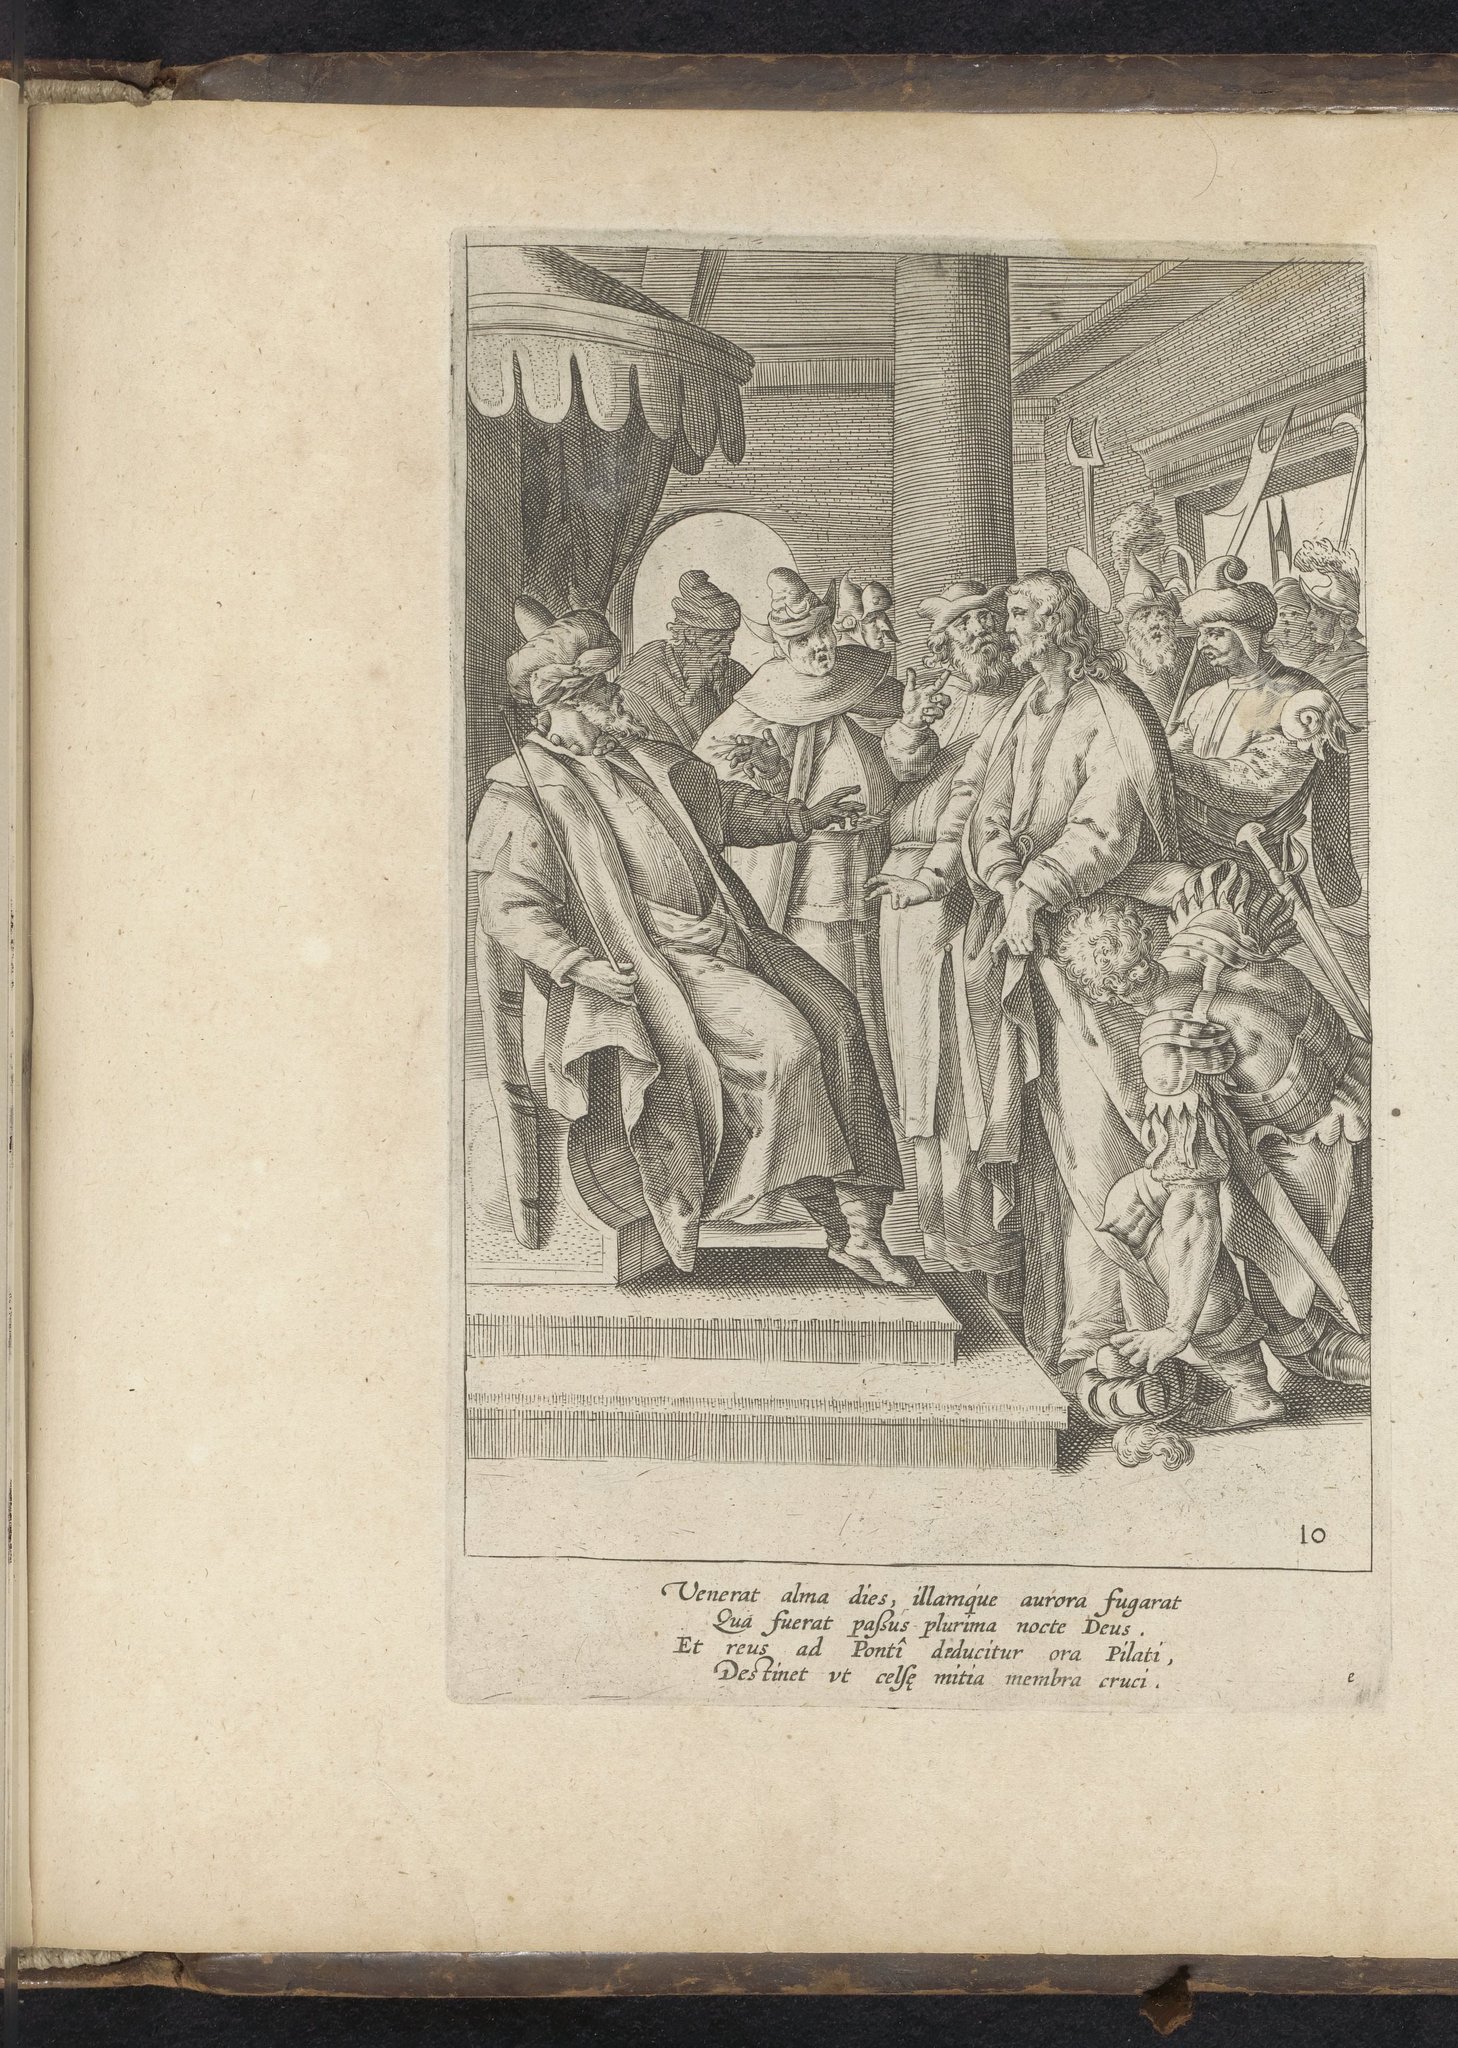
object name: print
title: Passie van Christus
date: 1585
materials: paper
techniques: engraving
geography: alkmaar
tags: christ before pontius pilate (matthew 27:11-26; mark 15:2-15; luke 23:2-7, 23:13-25; john 18:28 - 19:16)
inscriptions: number: ‘137’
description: Christus wordt door gewapende soldaten voor Pilatus gebracht. Pilatus zit op zijn troon en vraagt hem of hij de koning van de Joden is. Onder de voorstelling een vierregelig vers in het Latijn. Rechtsonder de letter: e. Deze prent maakt deel uit van een album.